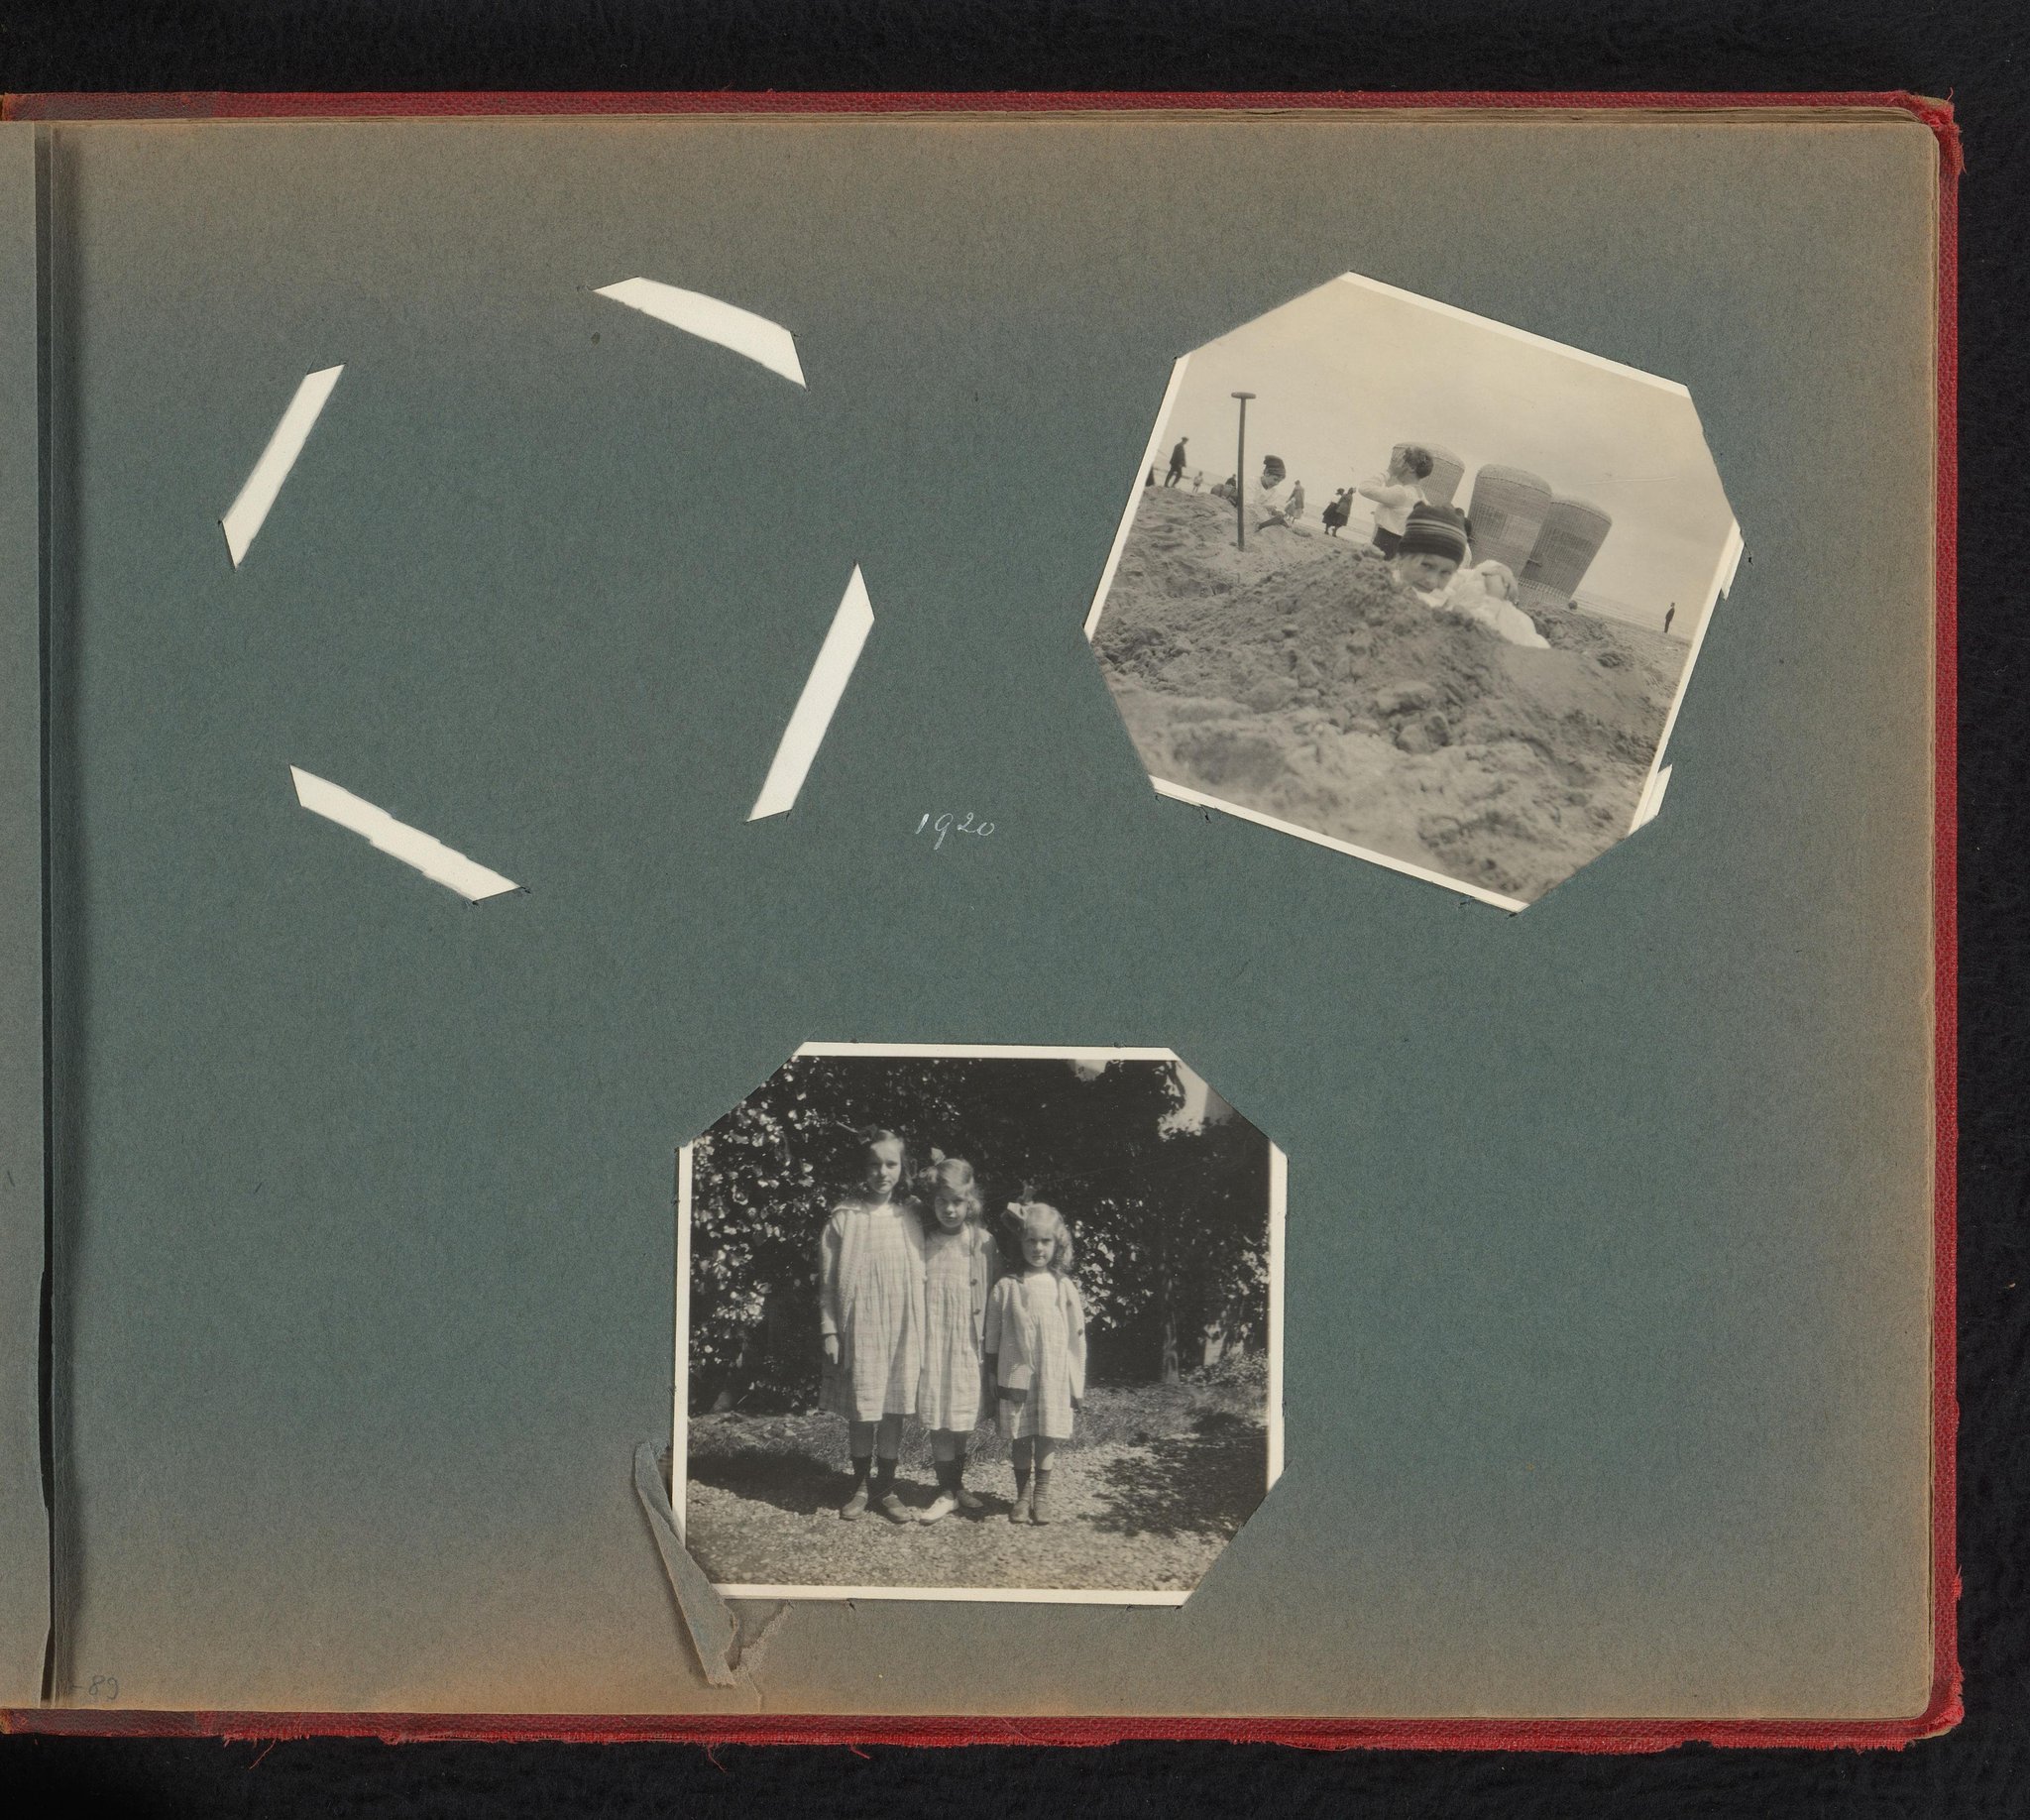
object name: album leaf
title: Eva en Hetty Boelen op het strand van Zandvoort en in de tuin van Amstel 244 in Amsterdam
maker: charlotte alida boelen-matthes (lot)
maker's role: amateurfotograaf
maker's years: 1889-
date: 1920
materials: paper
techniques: gelatin silver print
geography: netherlands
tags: beach (as place of recreation), garden, amsterdam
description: Deze foto's zijn onderdeel van een album.